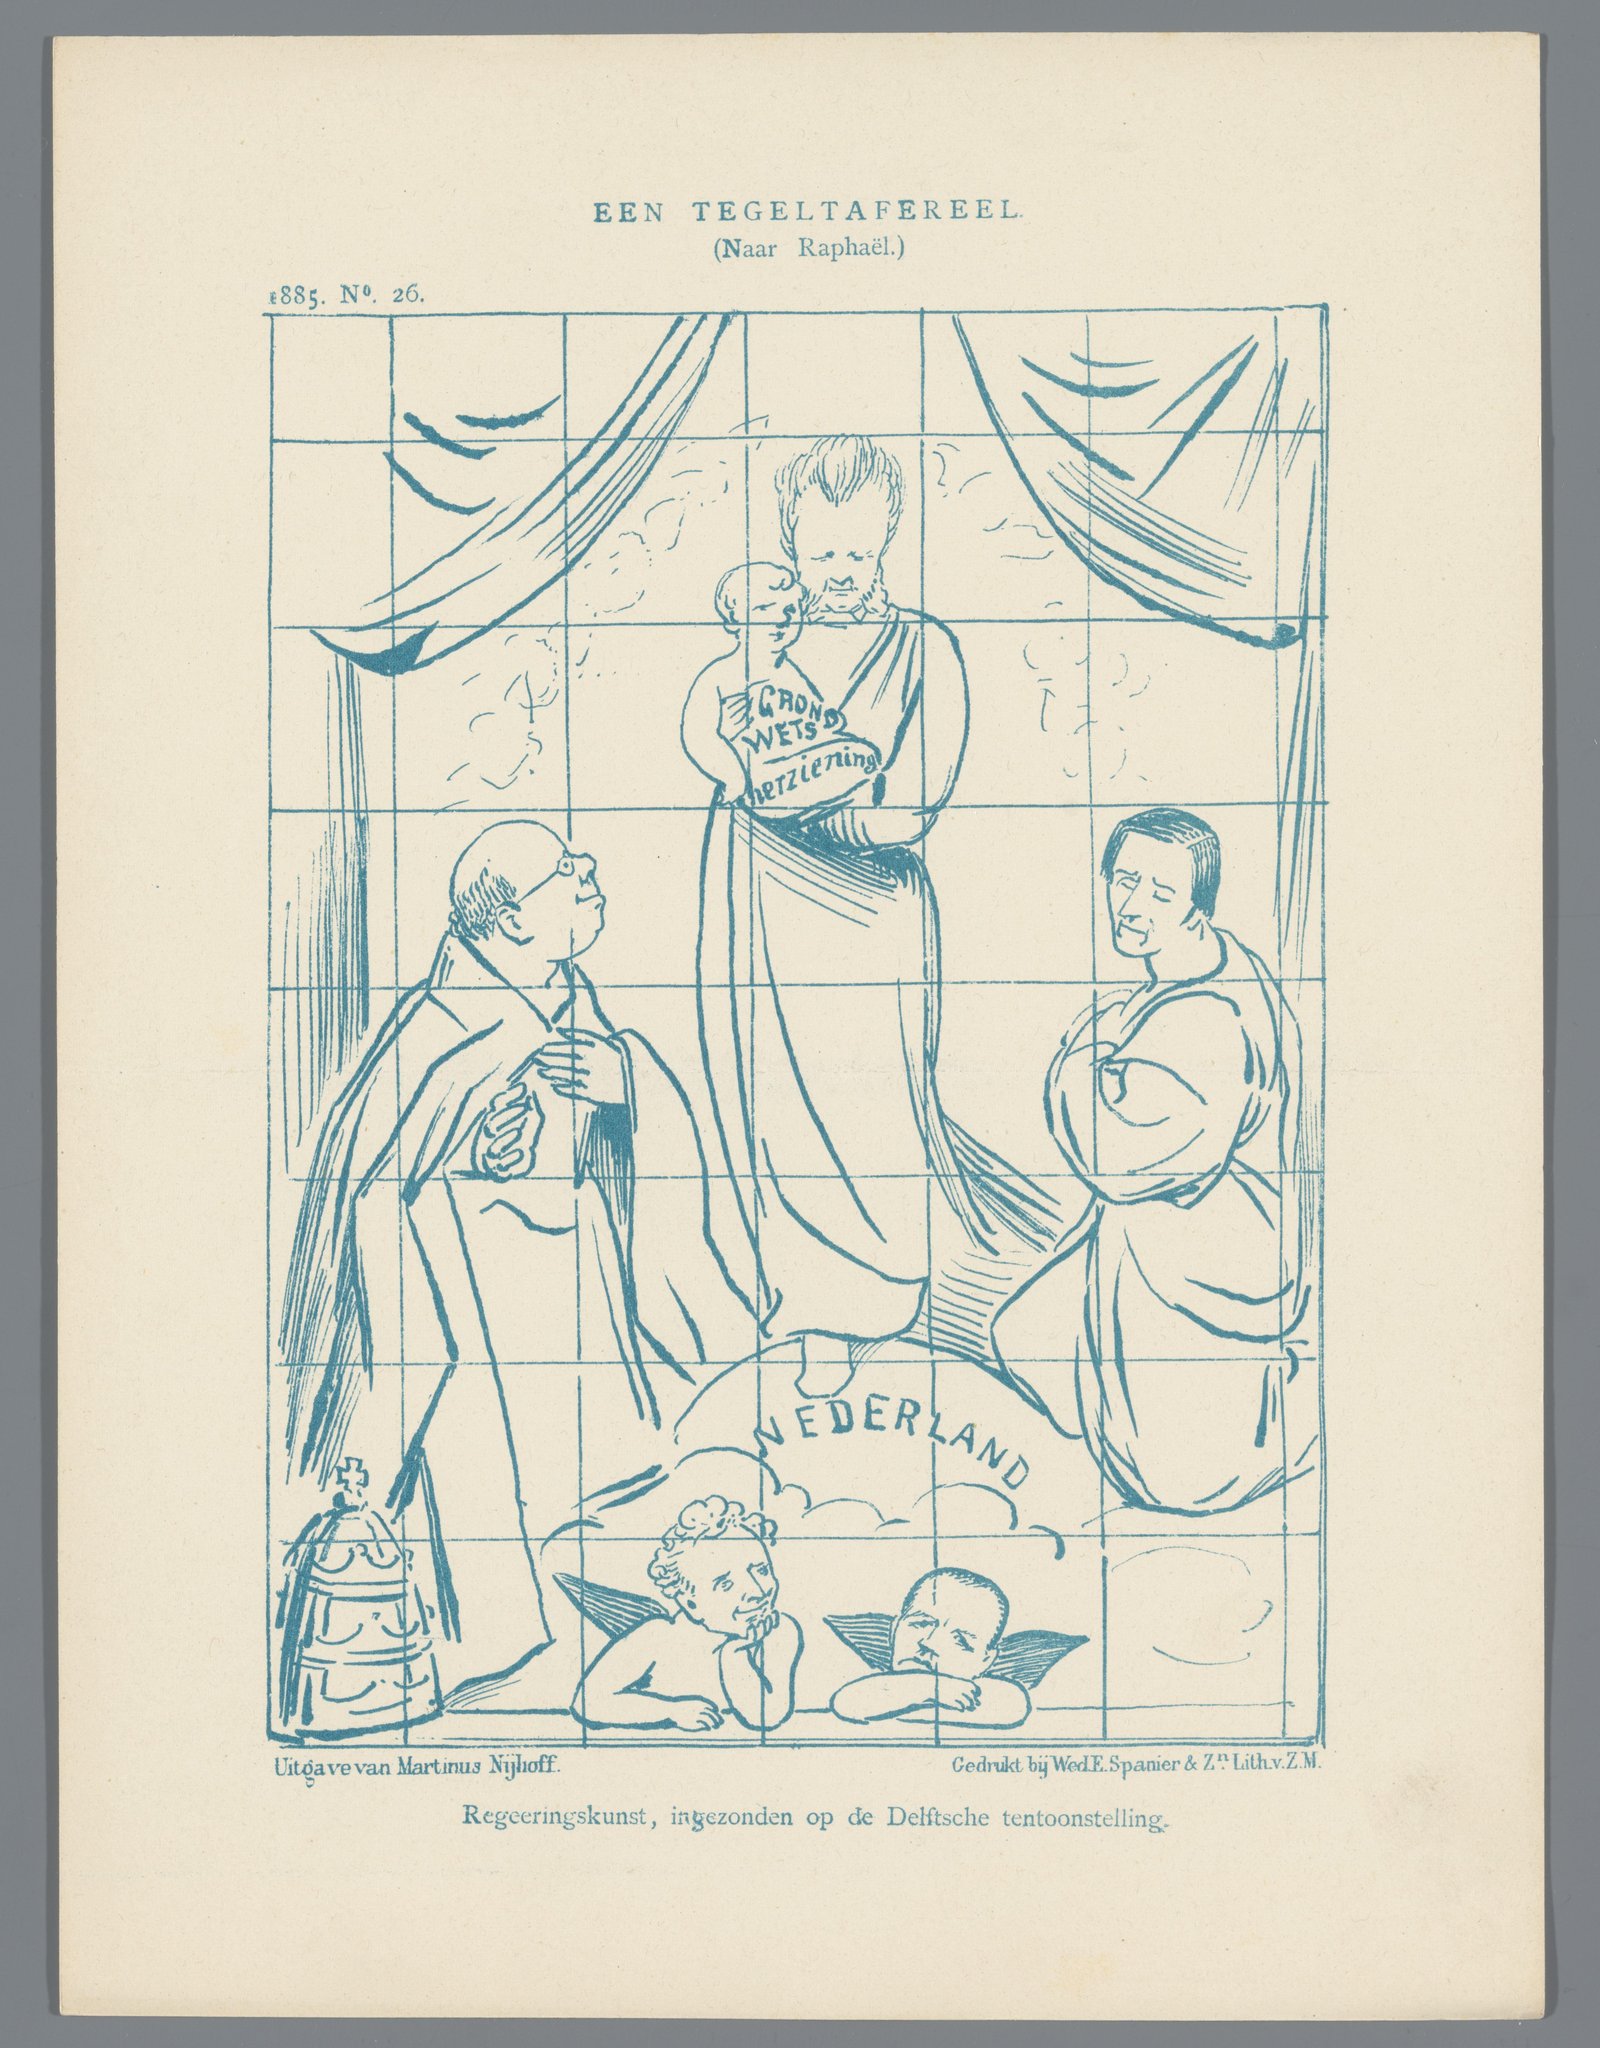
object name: cartoon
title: Spotprent op de grondwetsherziening, 1885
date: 1885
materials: paper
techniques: lithograph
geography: the hague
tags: amsterdam, politician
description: Spotprent op de grondwetsherziening van Minister Heemskerk. In de vorm van een tegeltableau naar het schilderij van de Sixtijnse Madonna van Rafaël. Plaat verschenen bij het weekblad De Nederlandsche Spectator, nr. 26, 1885.